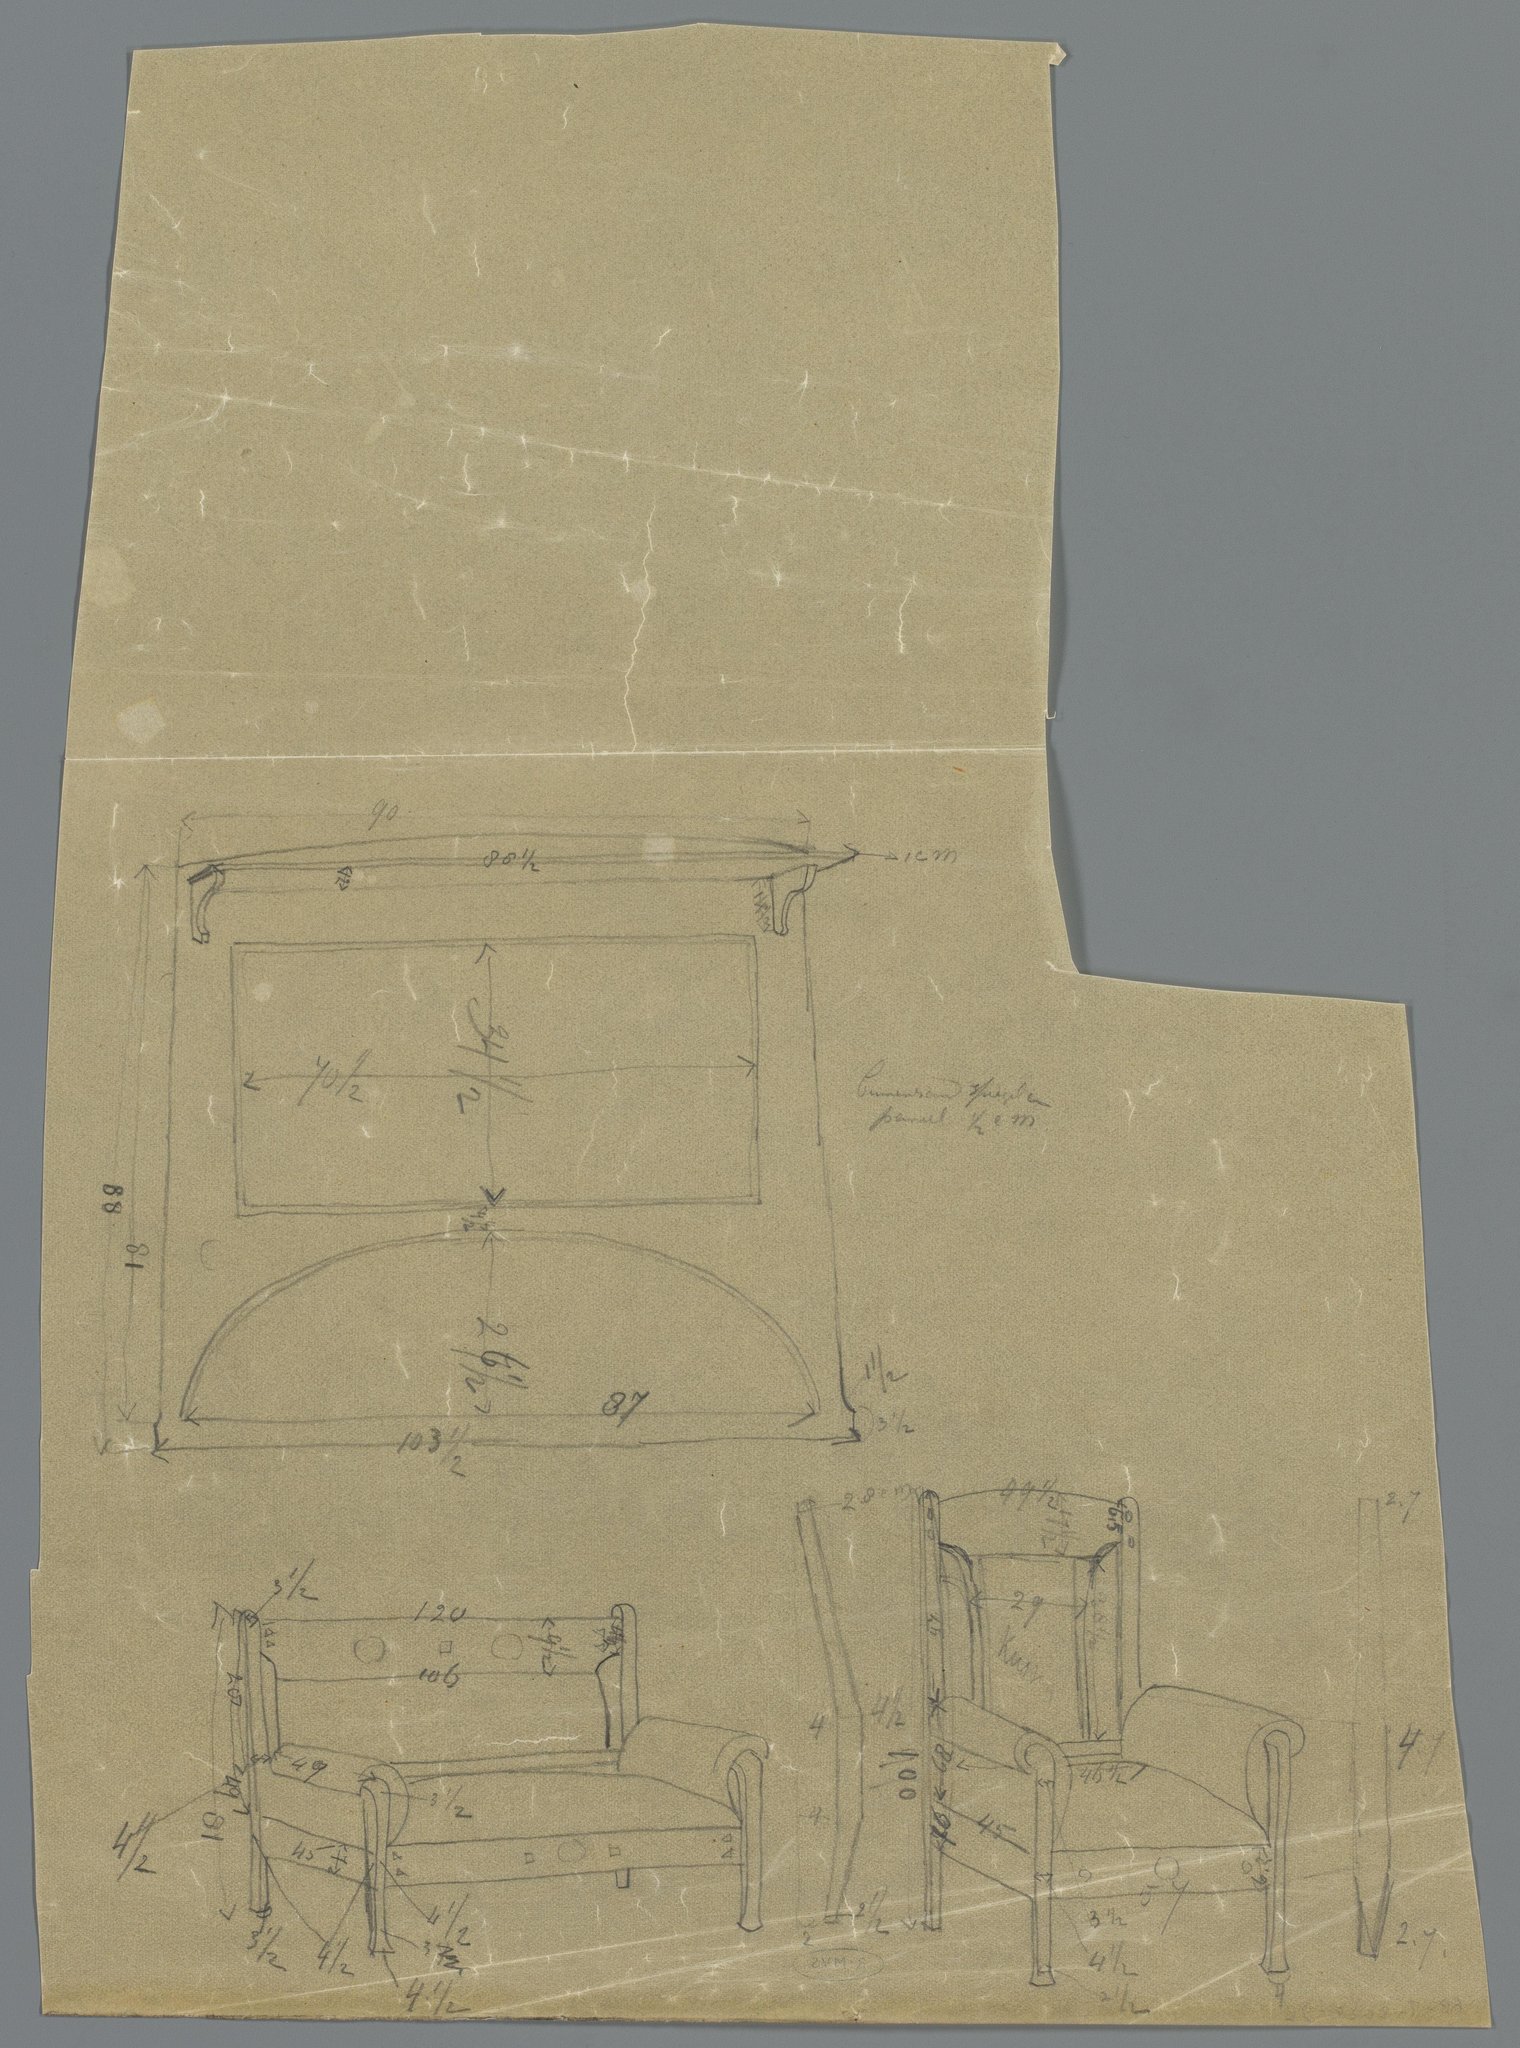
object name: design drawing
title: Ontwerp voor een meubel met spiegel, een bank en een stoel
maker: gust van de wall perné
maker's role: draughtsman, painter, print maker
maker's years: 1877-1911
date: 1887-1911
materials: pencil, paper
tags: decorative furniture, mirror, chair, couch, sofa, settee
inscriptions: collector's mark: Lugt 2228